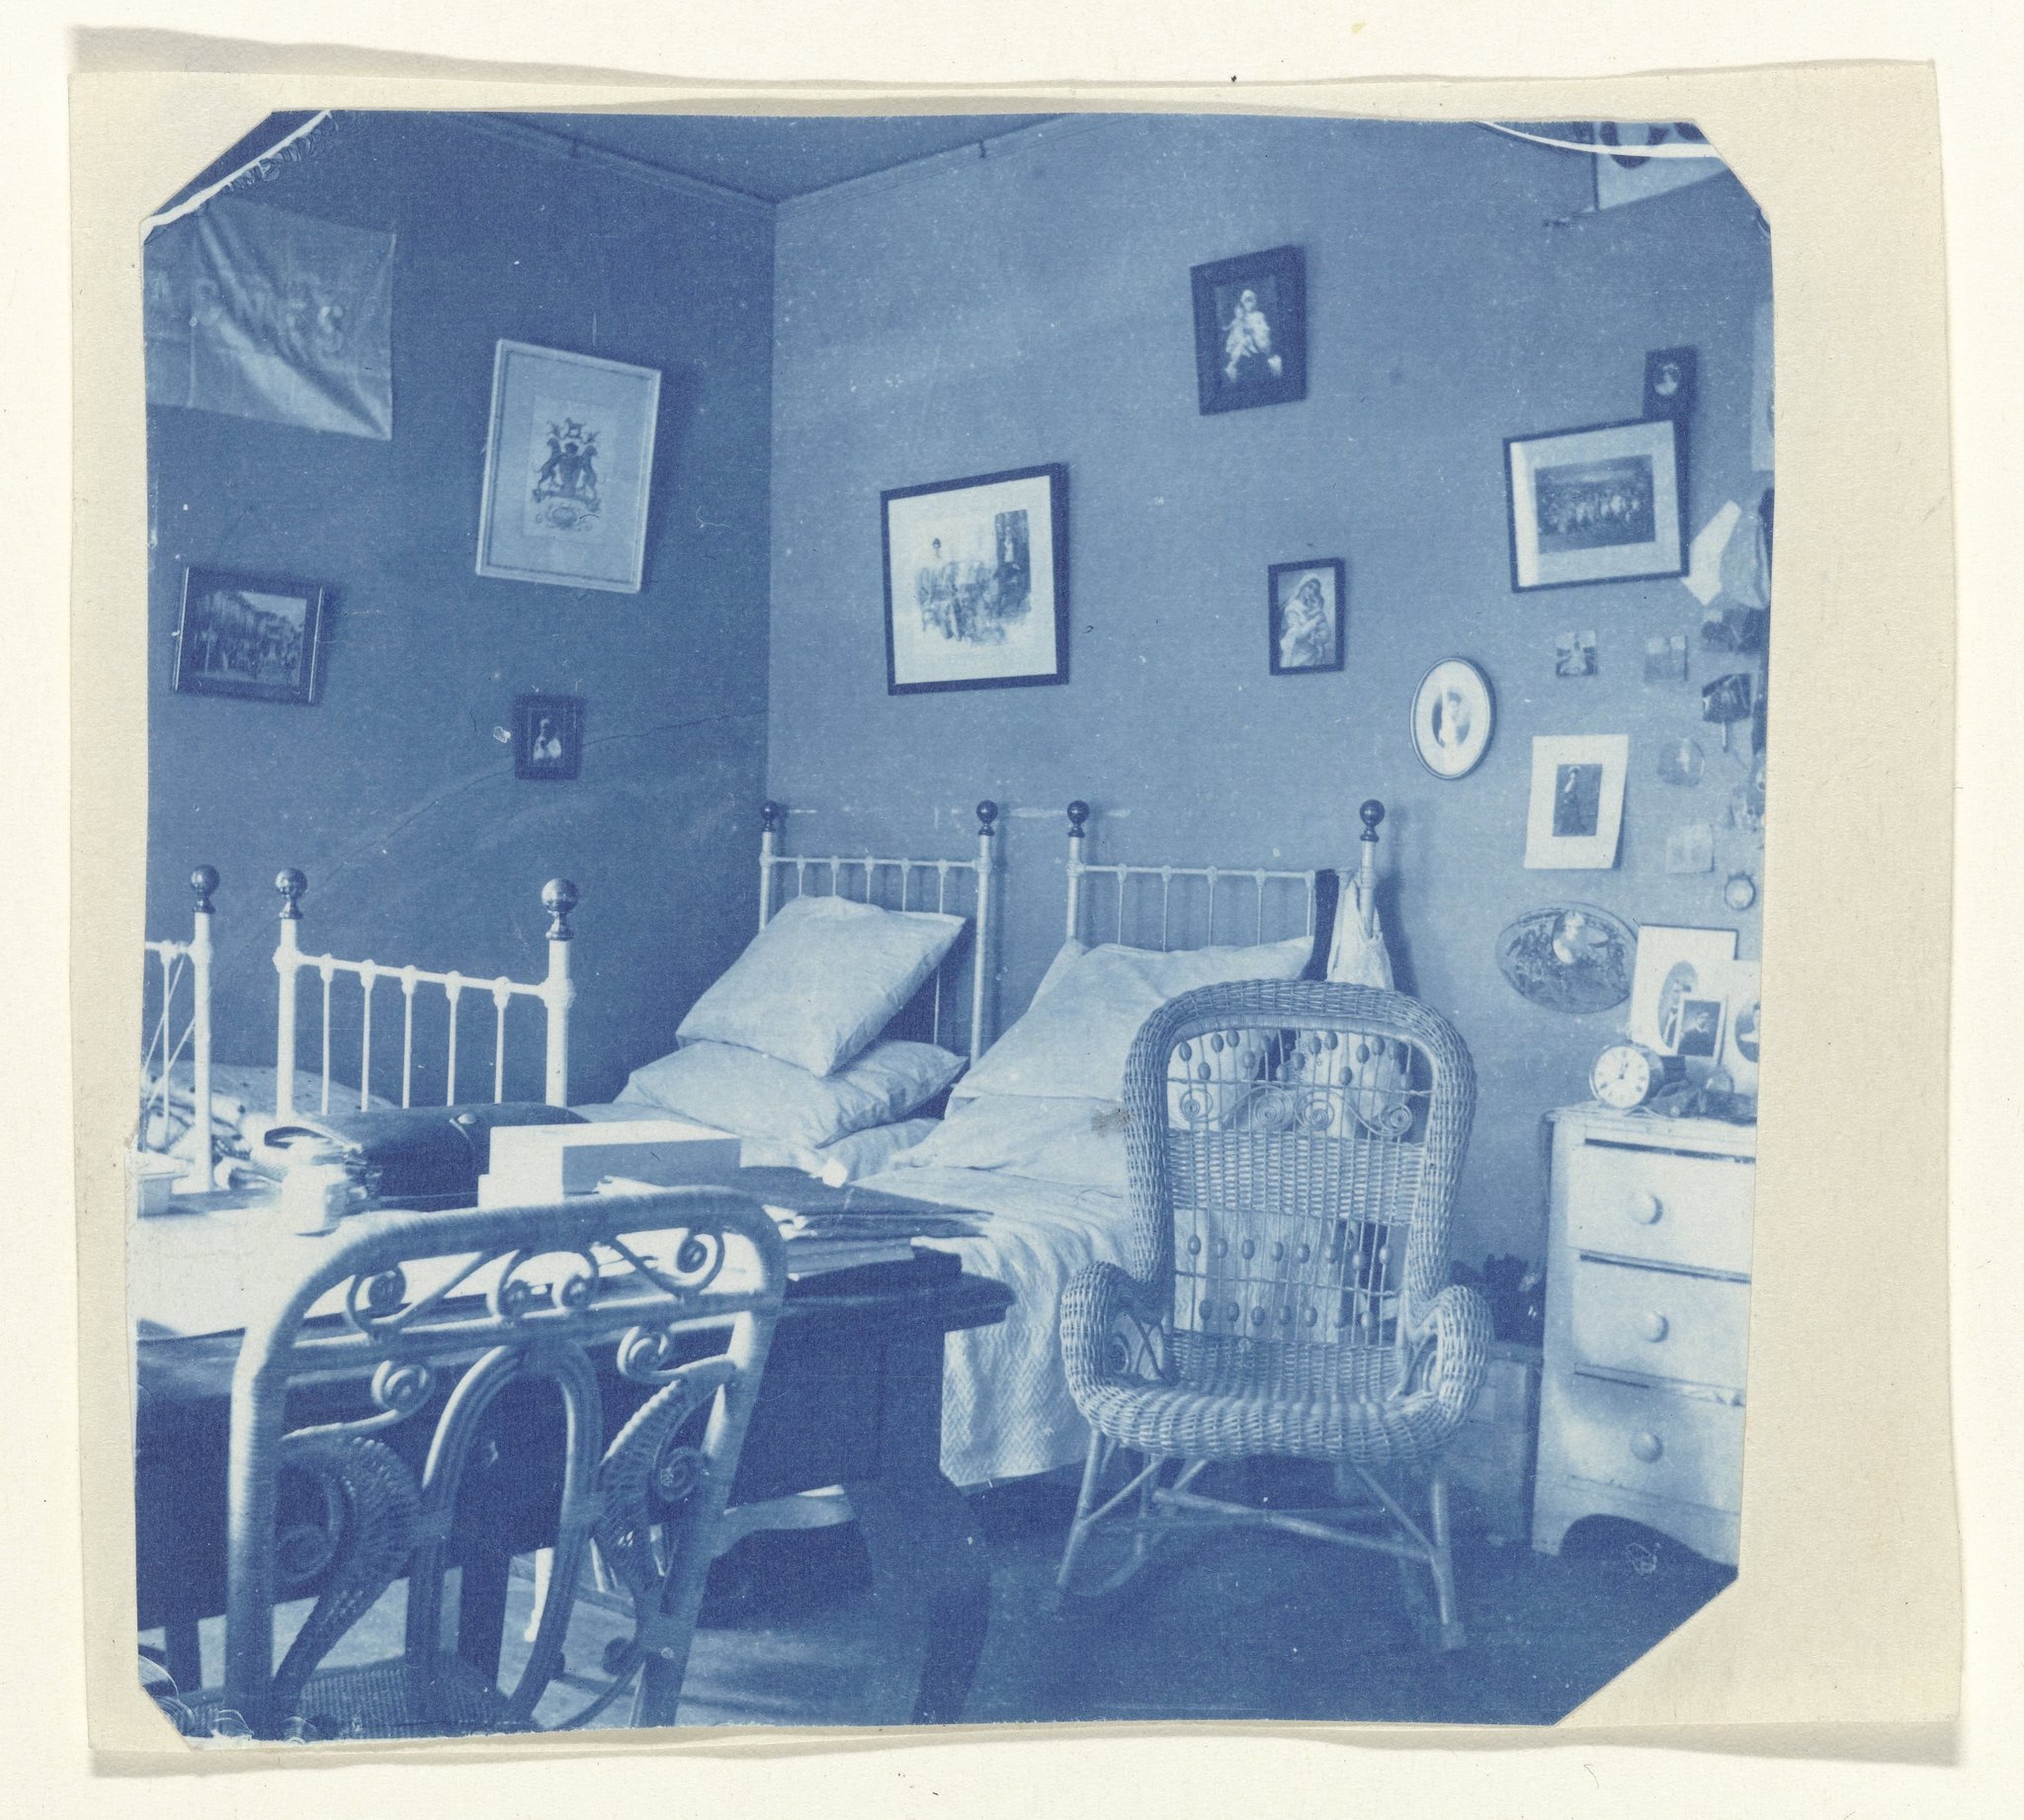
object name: photograph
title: Slaapkamer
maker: Anonymous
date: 1900-1910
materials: paper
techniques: cyanotype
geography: united states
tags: bedroom